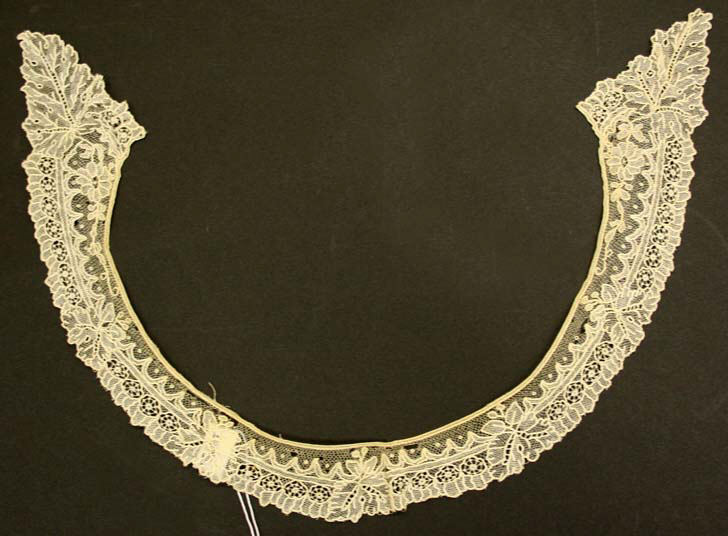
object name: collar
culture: european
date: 1861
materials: cotton